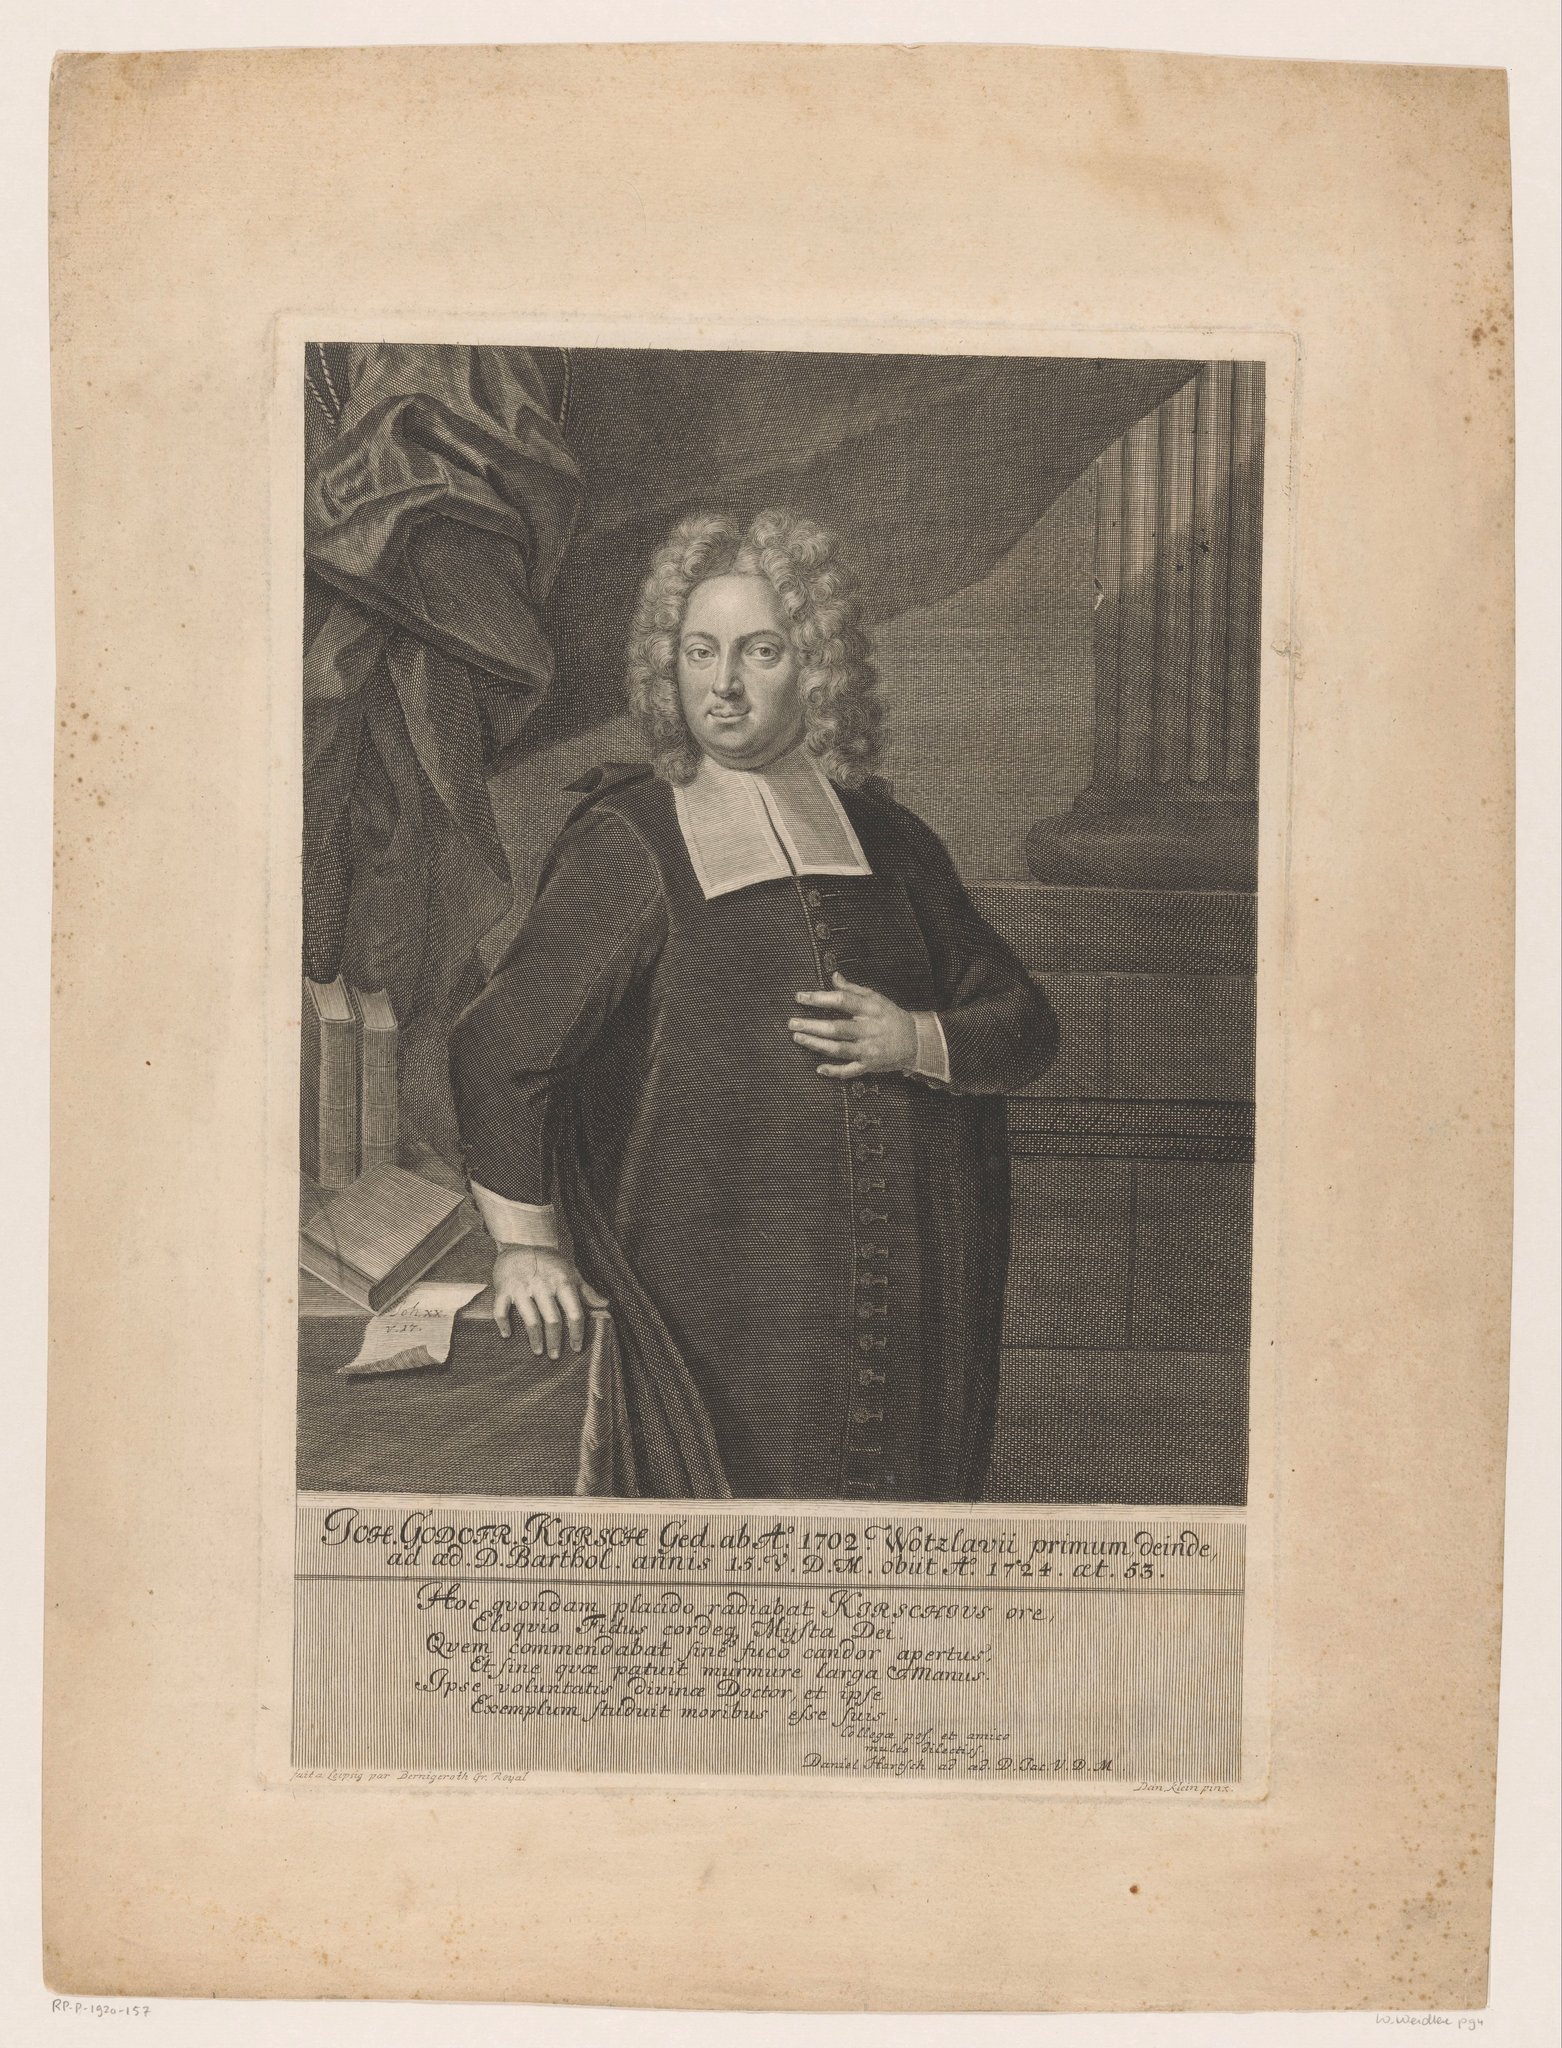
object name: print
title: Portret van Johann Gottfried Kirsch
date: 1724-1733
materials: paper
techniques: engraving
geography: leipzig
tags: historical persons, book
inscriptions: collector's mark: Lugt 2228